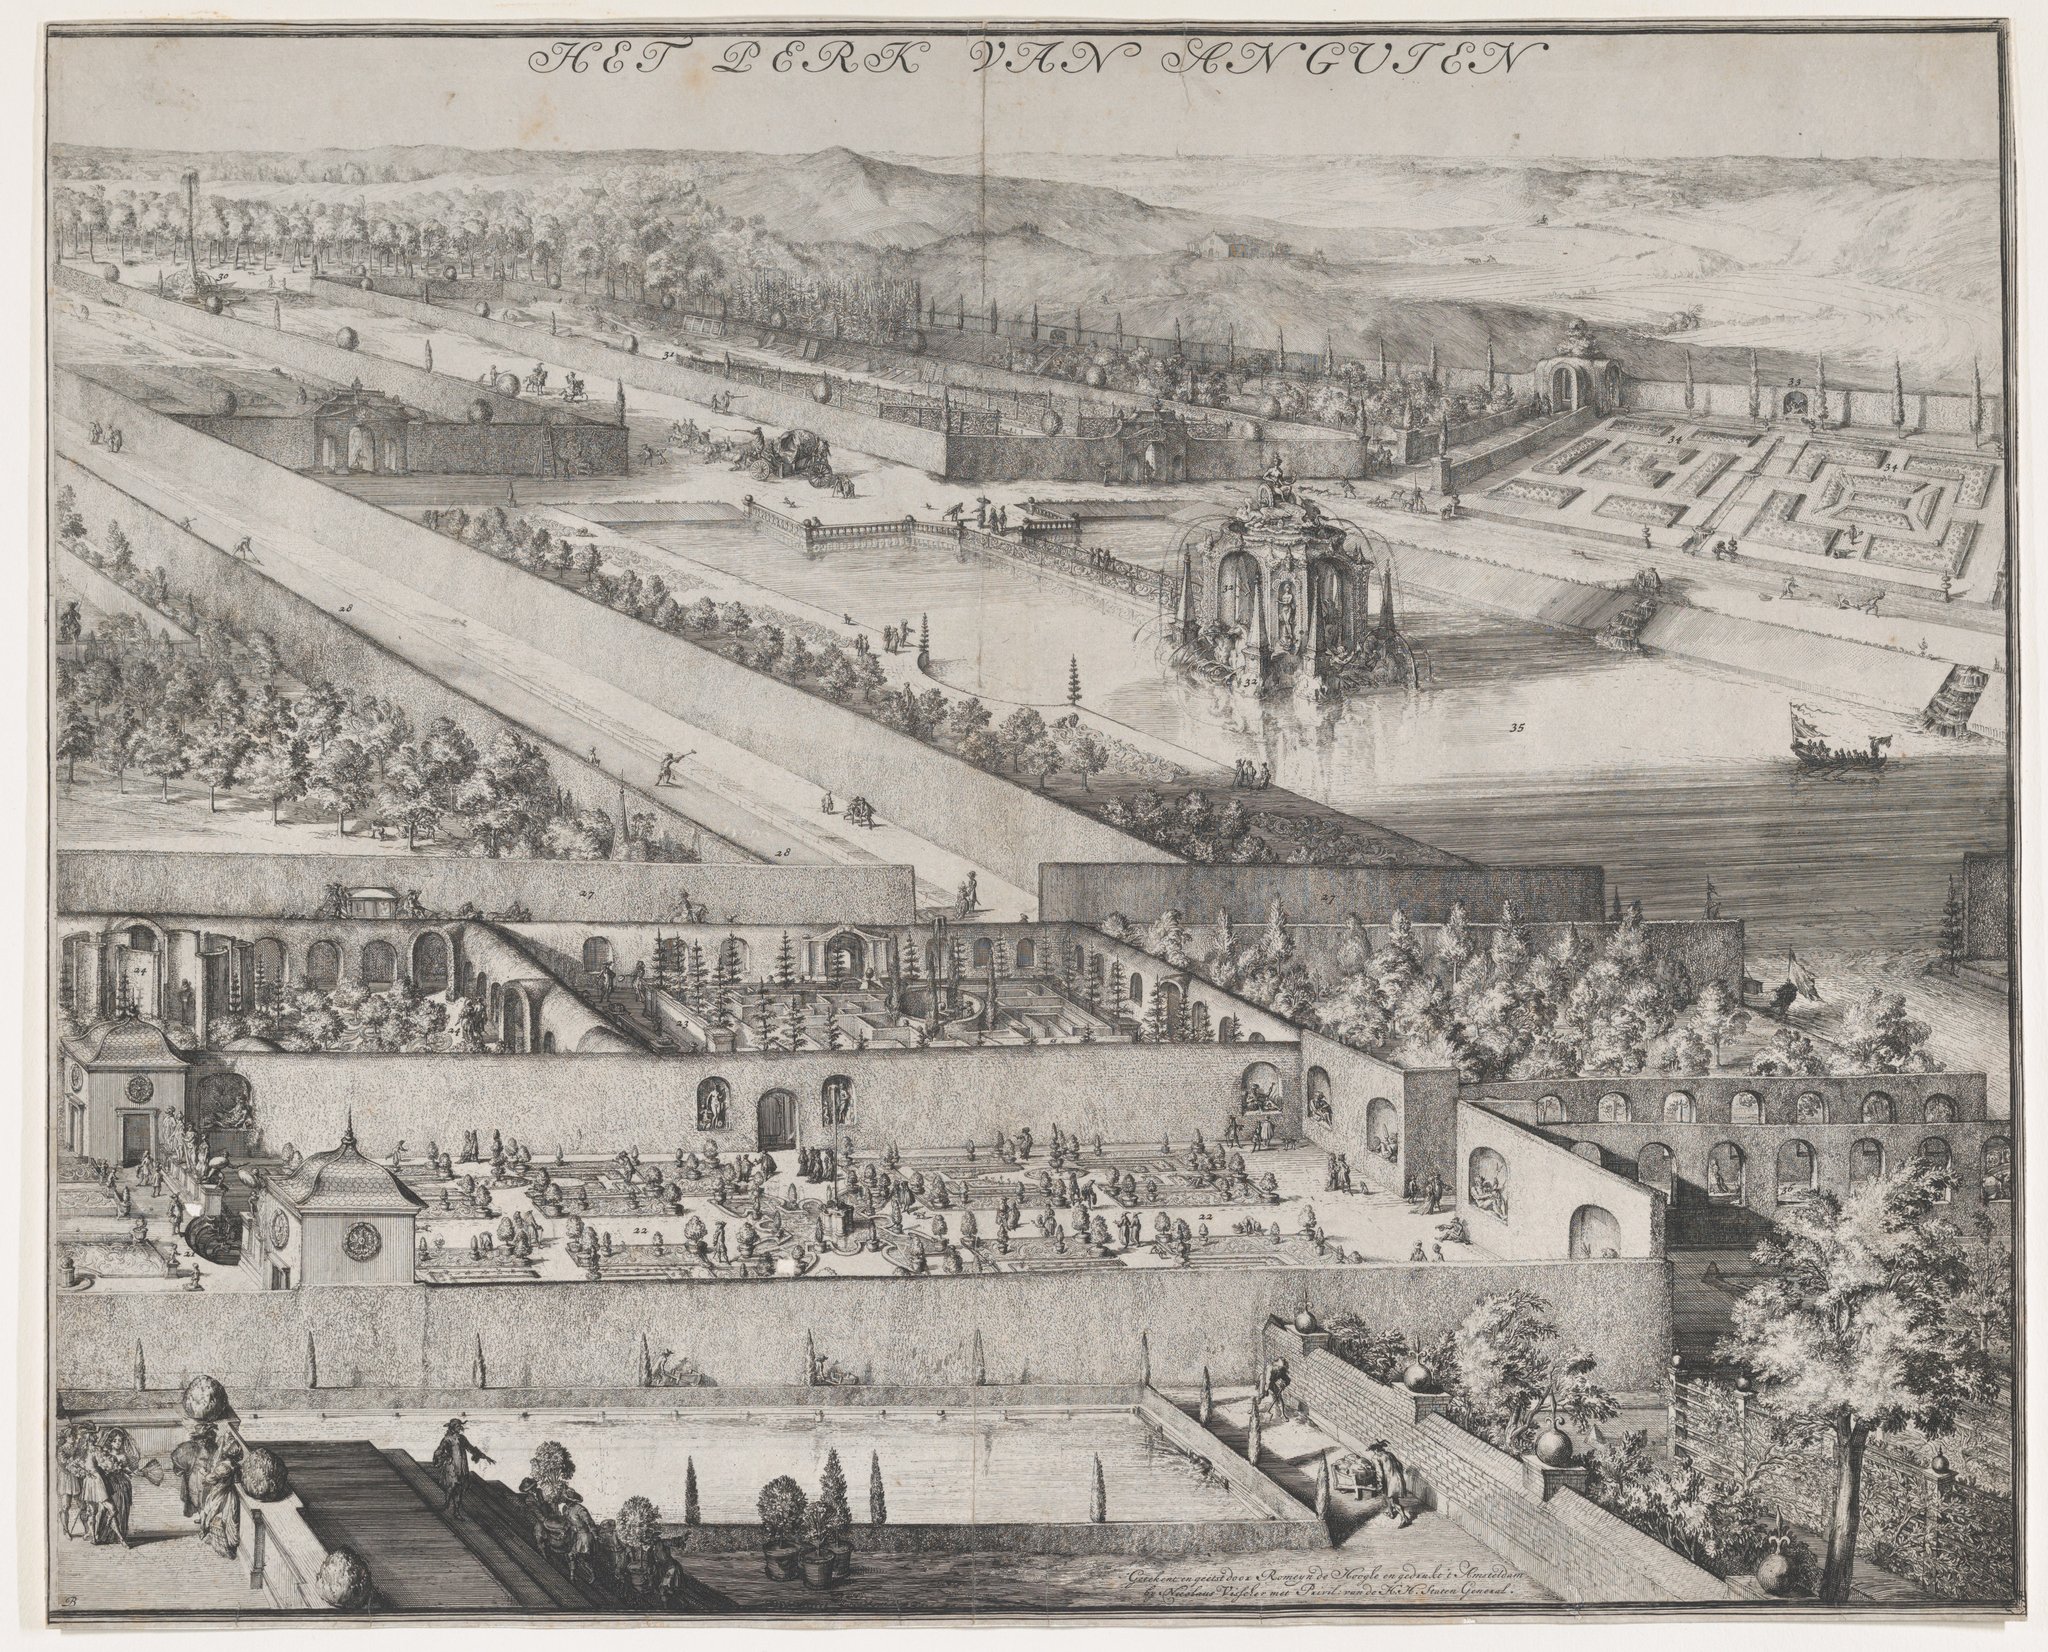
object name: print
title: Detail of the Park at Enghien (right half)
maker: romeyn de hooghe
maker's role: artist and engraver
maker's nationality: dutch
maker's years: 1645-1708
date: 1685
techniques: etching